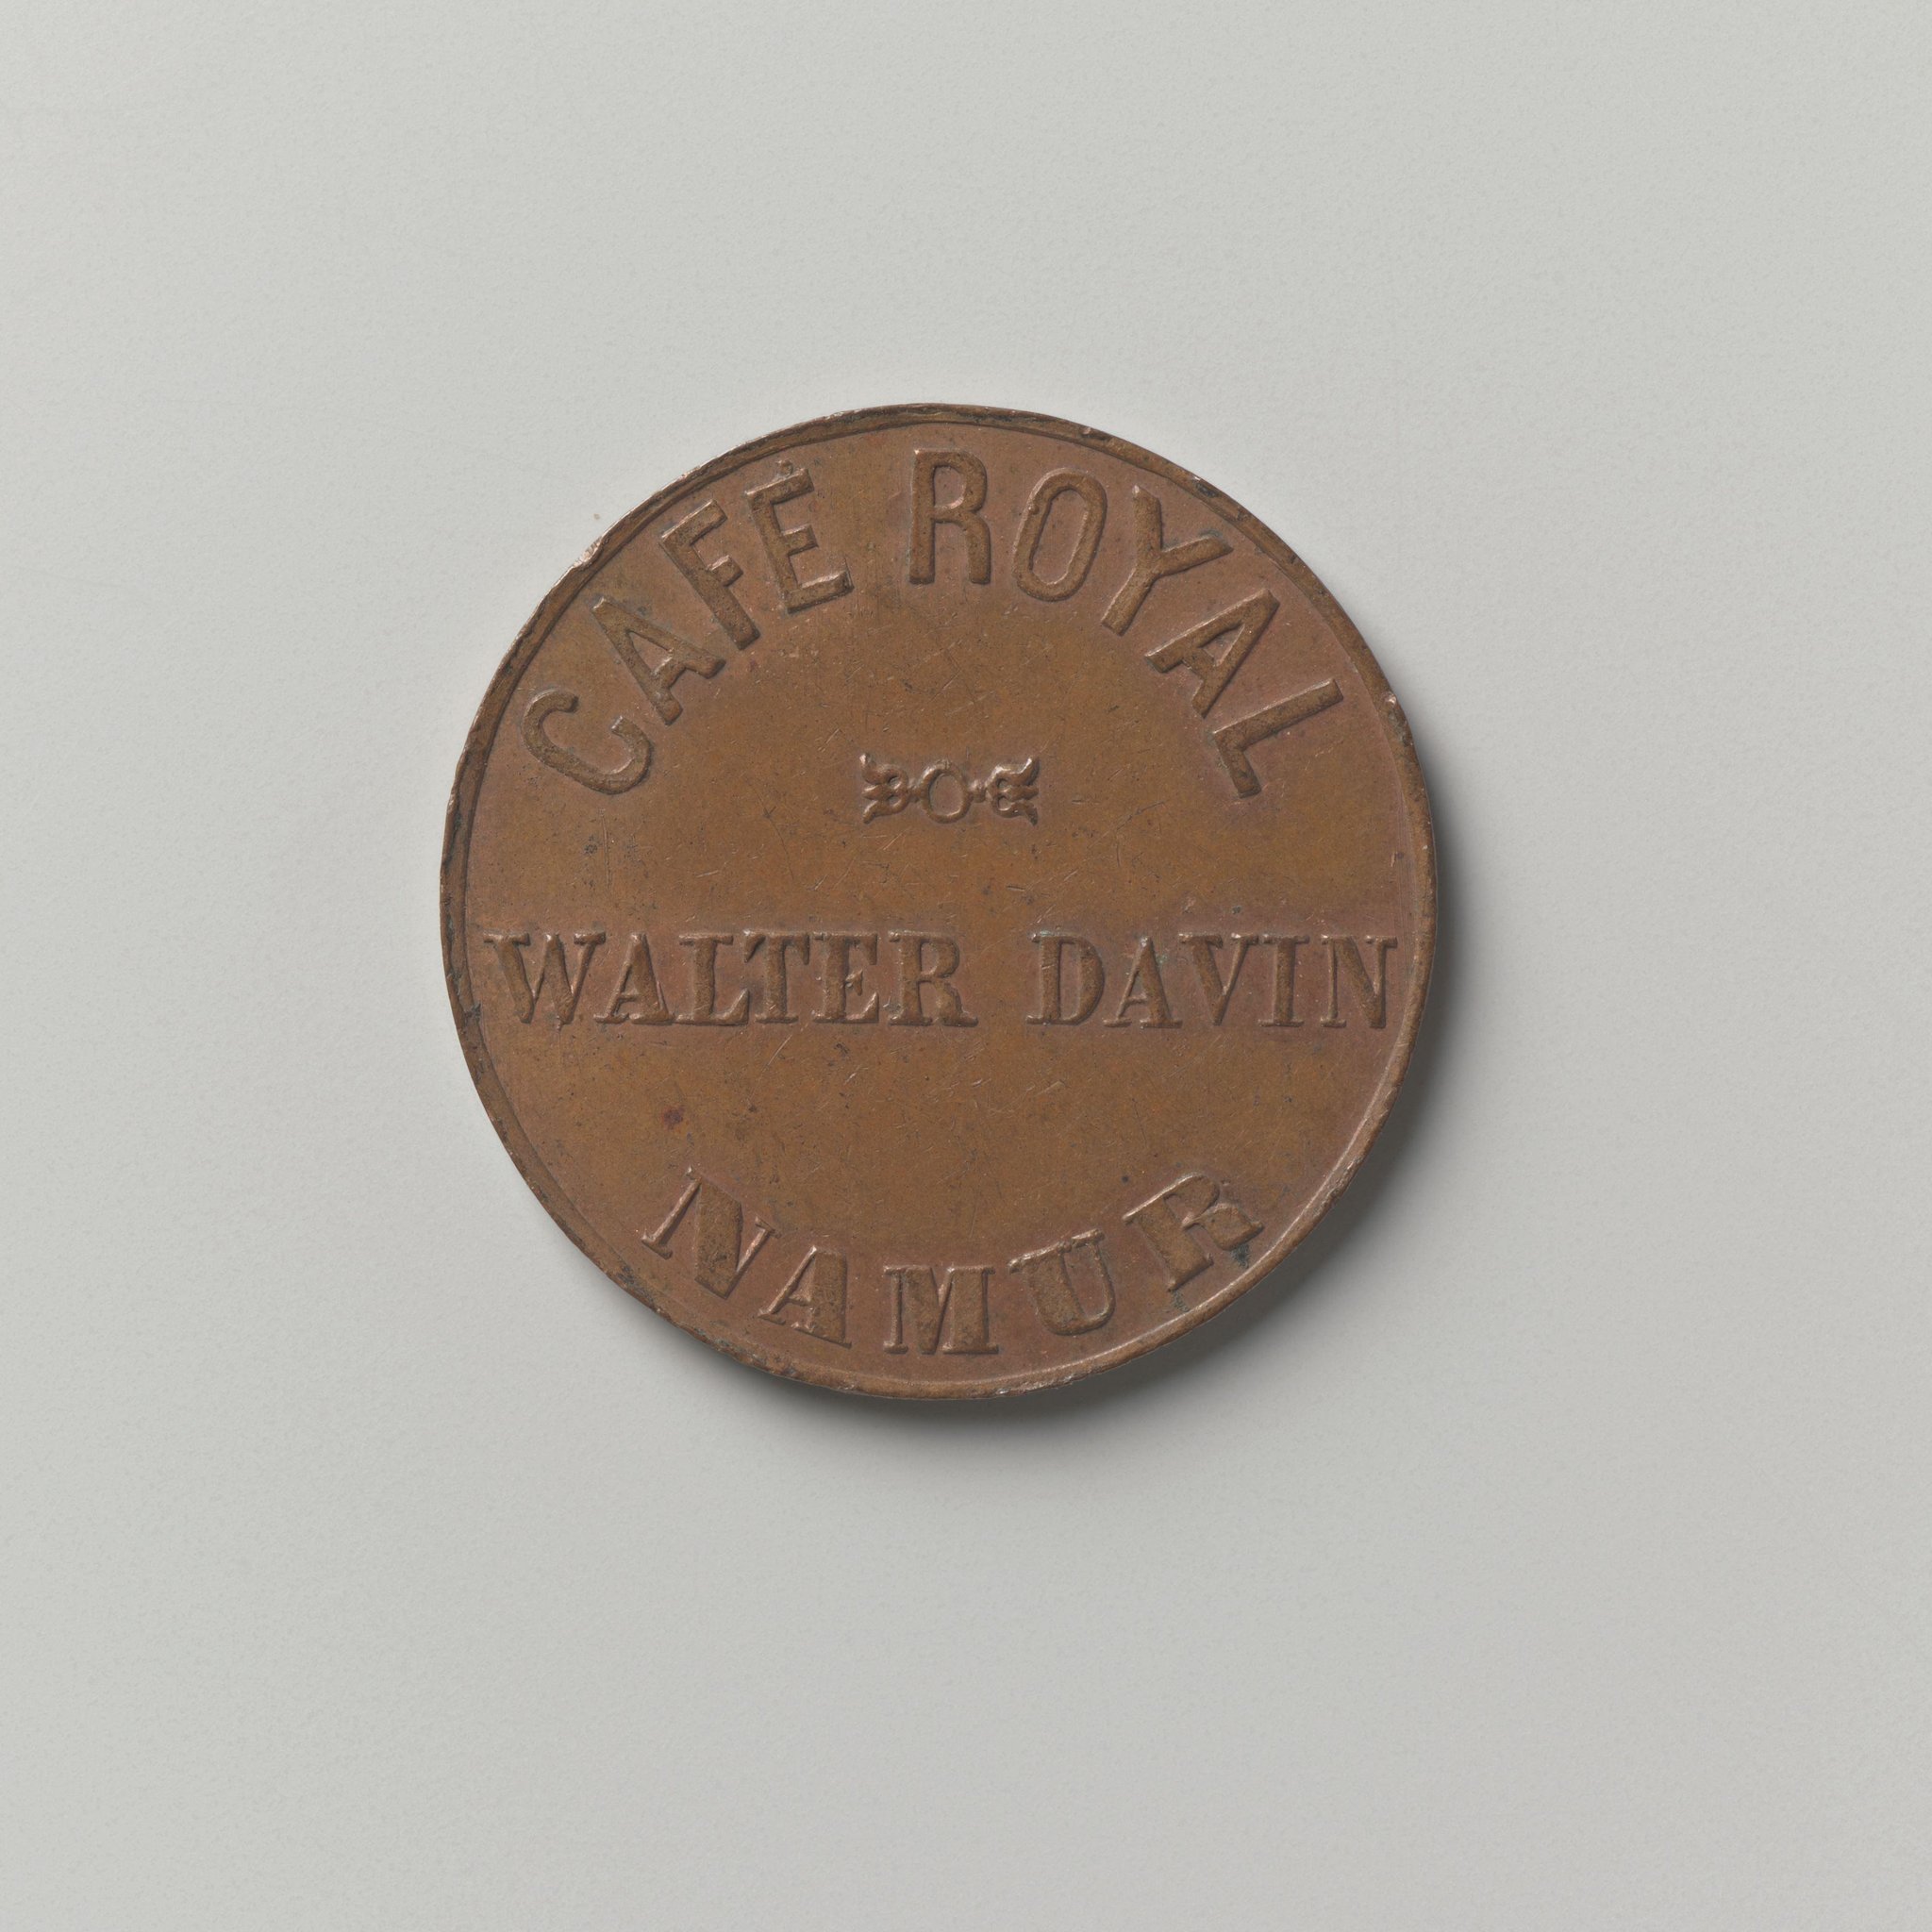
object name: vijfentwintig centime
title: Namen, café Royal, 25 centimes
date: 1800-1900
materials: copper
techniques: striking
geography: namur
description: Koperen munt. Huismunt. Voorzijde: waarde-aanduiding 25. Keerzijde: versiering, waaronder eenregelig opschrift. Omschrift.